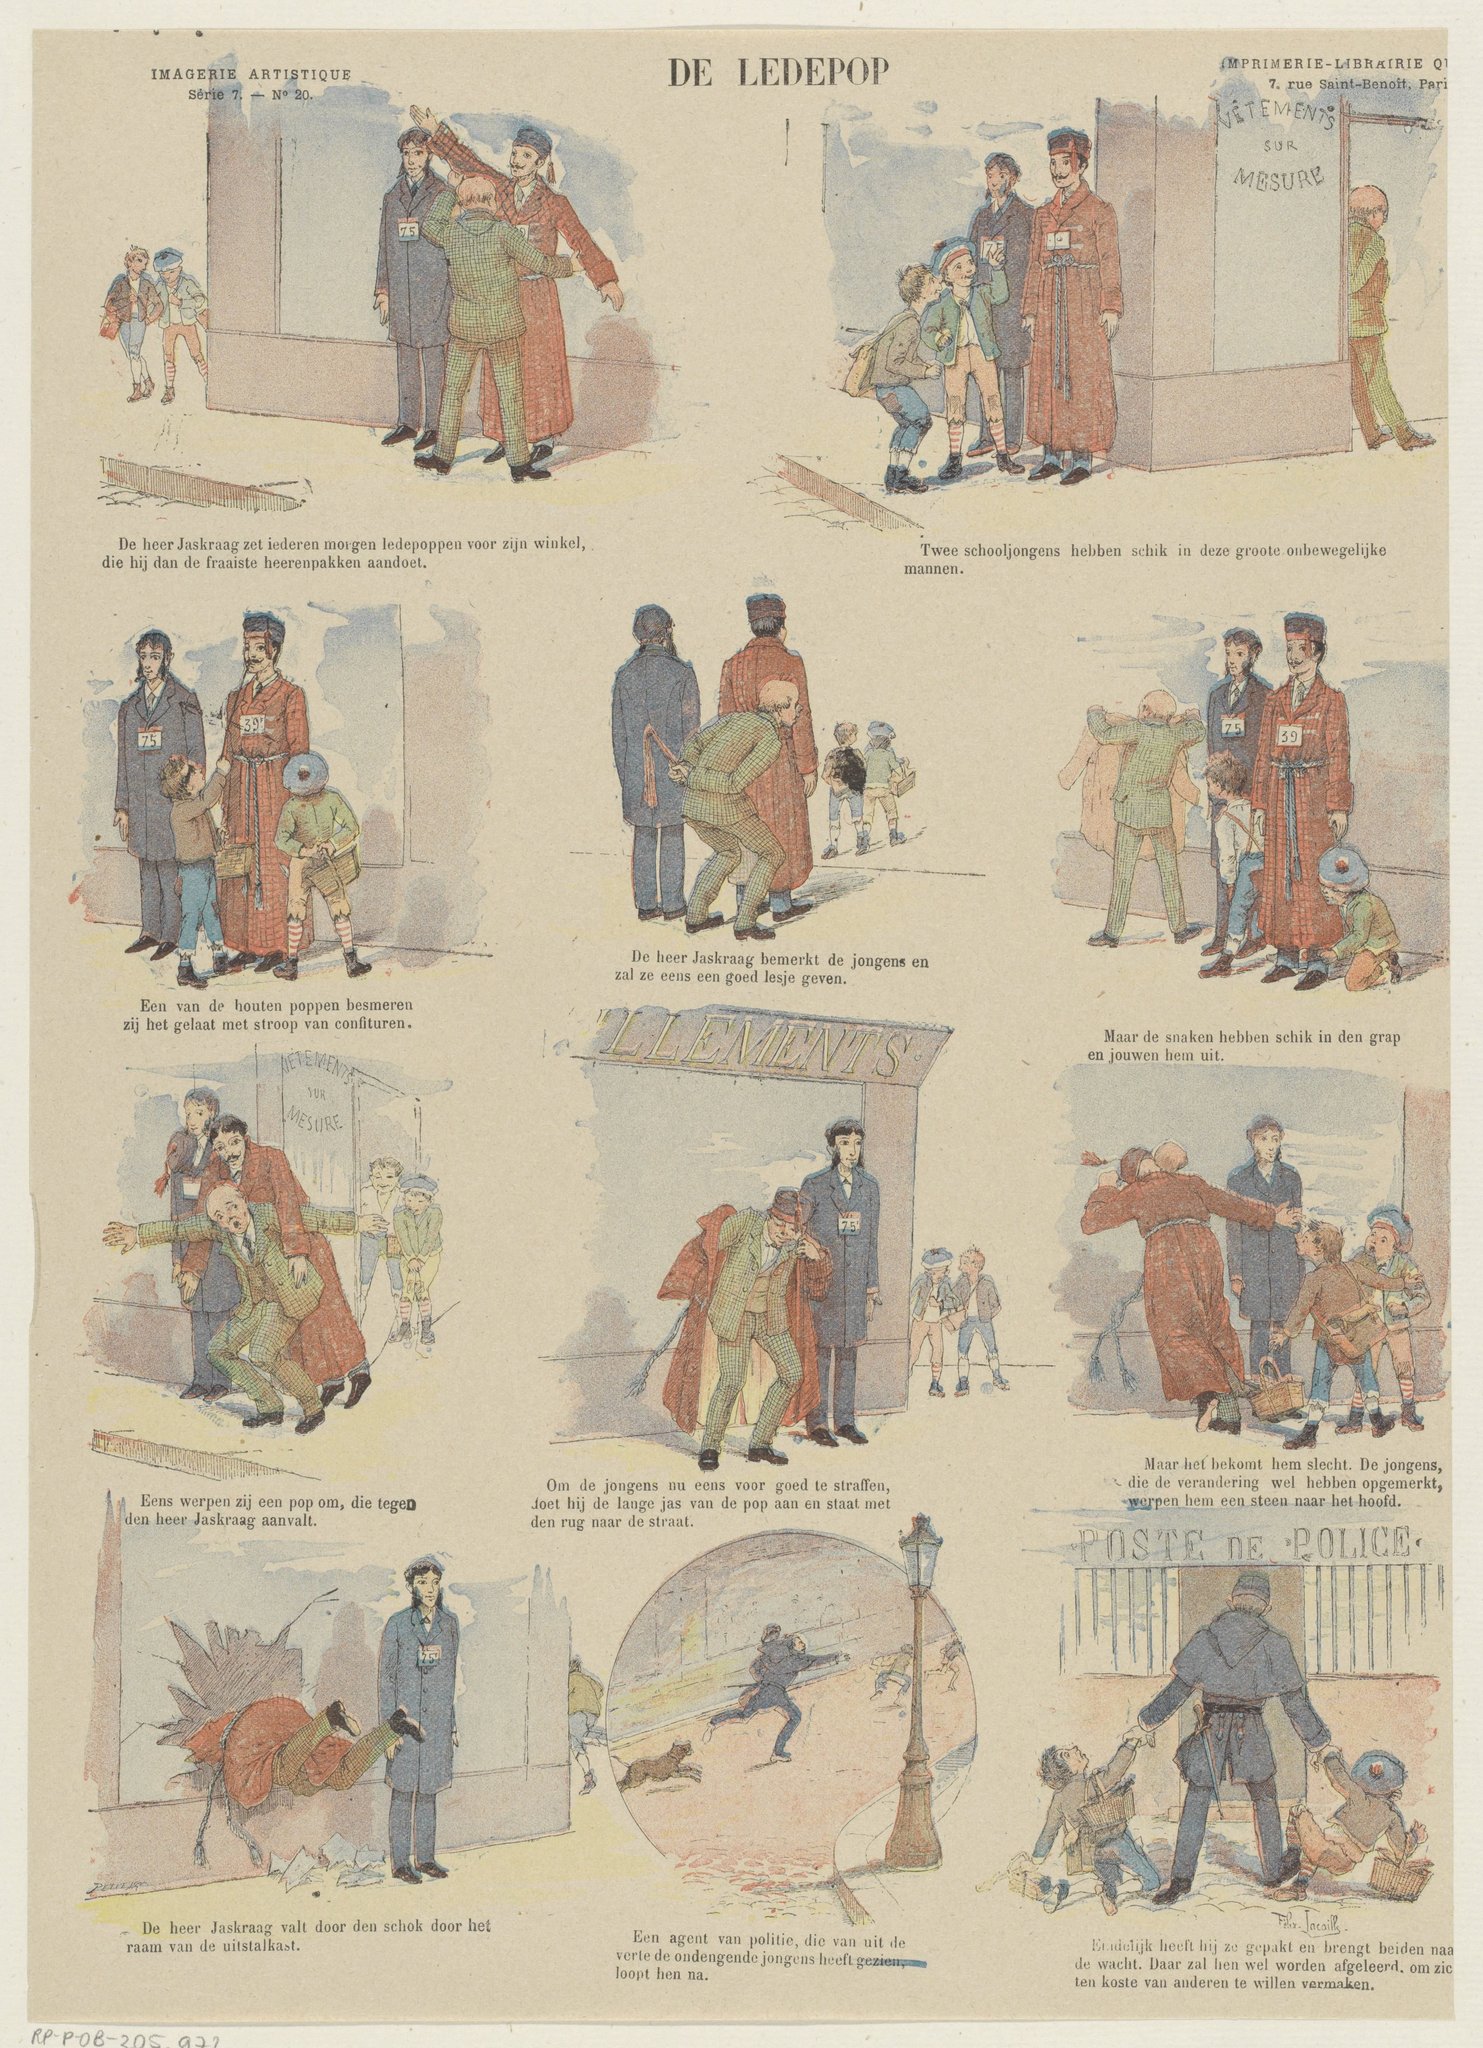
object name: popular print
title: De ledepop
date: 1876-1890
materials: paper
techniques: lithograph, letterpress printing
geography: paris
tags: mischief-making play, correction of naughty children, bad behaviour, tales and fairy tales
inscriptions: collector's mark: Lugt 2760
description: Blad met 11 voorstellingen van twee kwajongens die streken uithalen met de paspoppen van de heer Jaskraag. Onder elke voorstelling een onderschrift. Genummerd linksboven: Série 7. - No. 20.